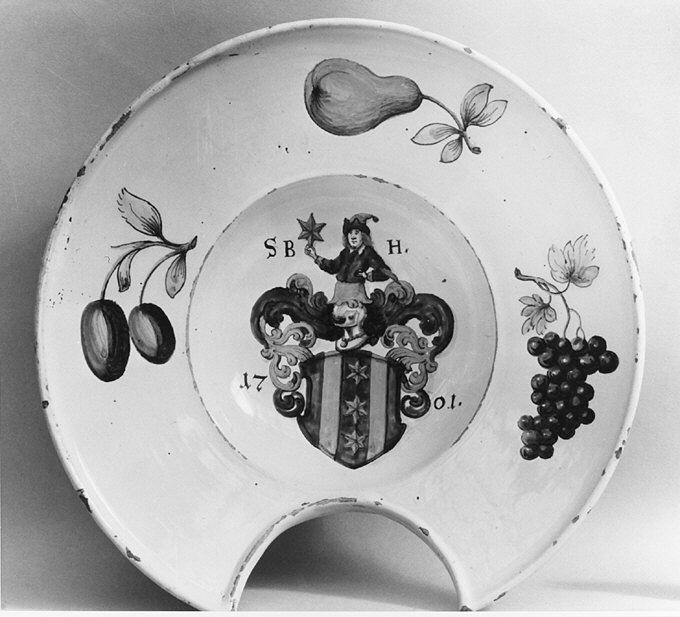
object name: barber's basin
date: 1701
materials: faience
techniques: glazing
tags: fruit,women,coat of arms